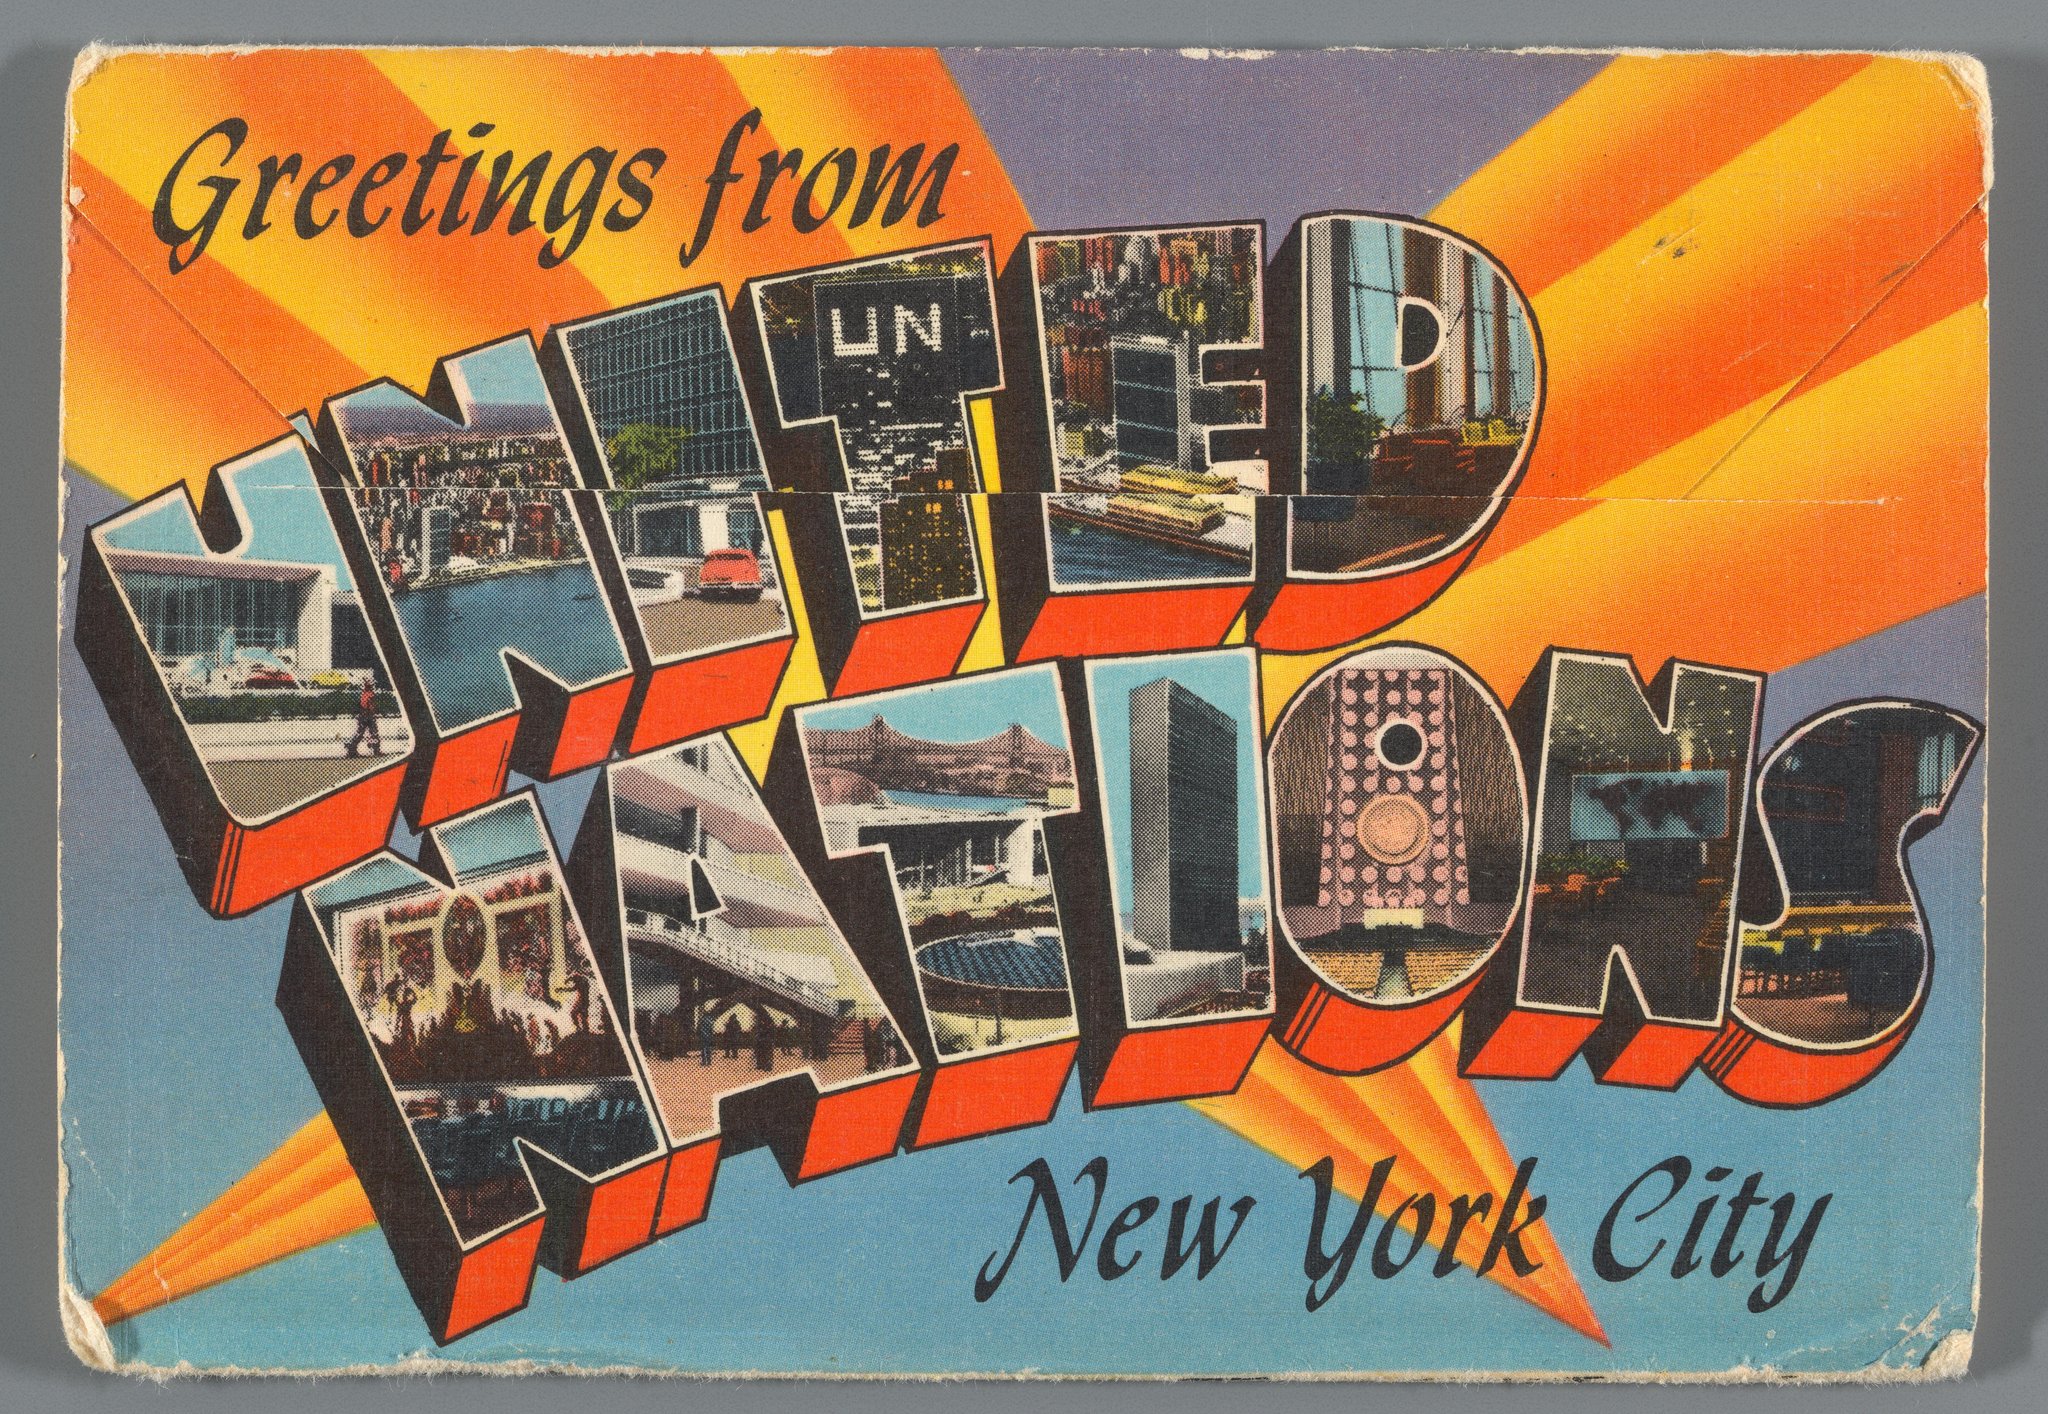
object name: ansichtkaart, prentbriefkaart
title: Leporello van prentbriefkaarten met foto-omslag ‘United Nations/ New York City’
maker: Anonymous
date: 1956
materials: paper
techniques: offset printed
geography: united states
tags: united nations, new york (city)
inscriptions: inscription